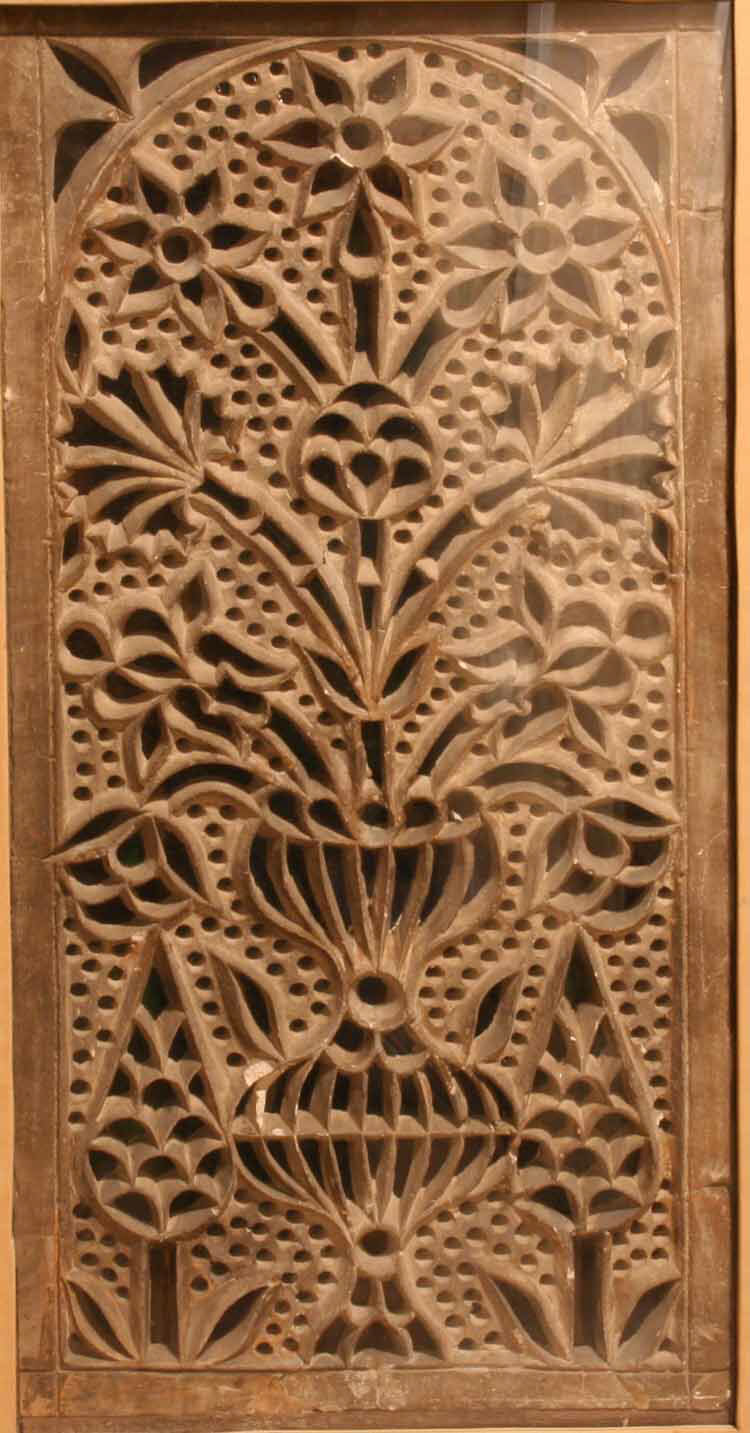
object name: window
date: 1701-1800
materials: gypsum, glass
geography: egypt or syria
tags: flowers